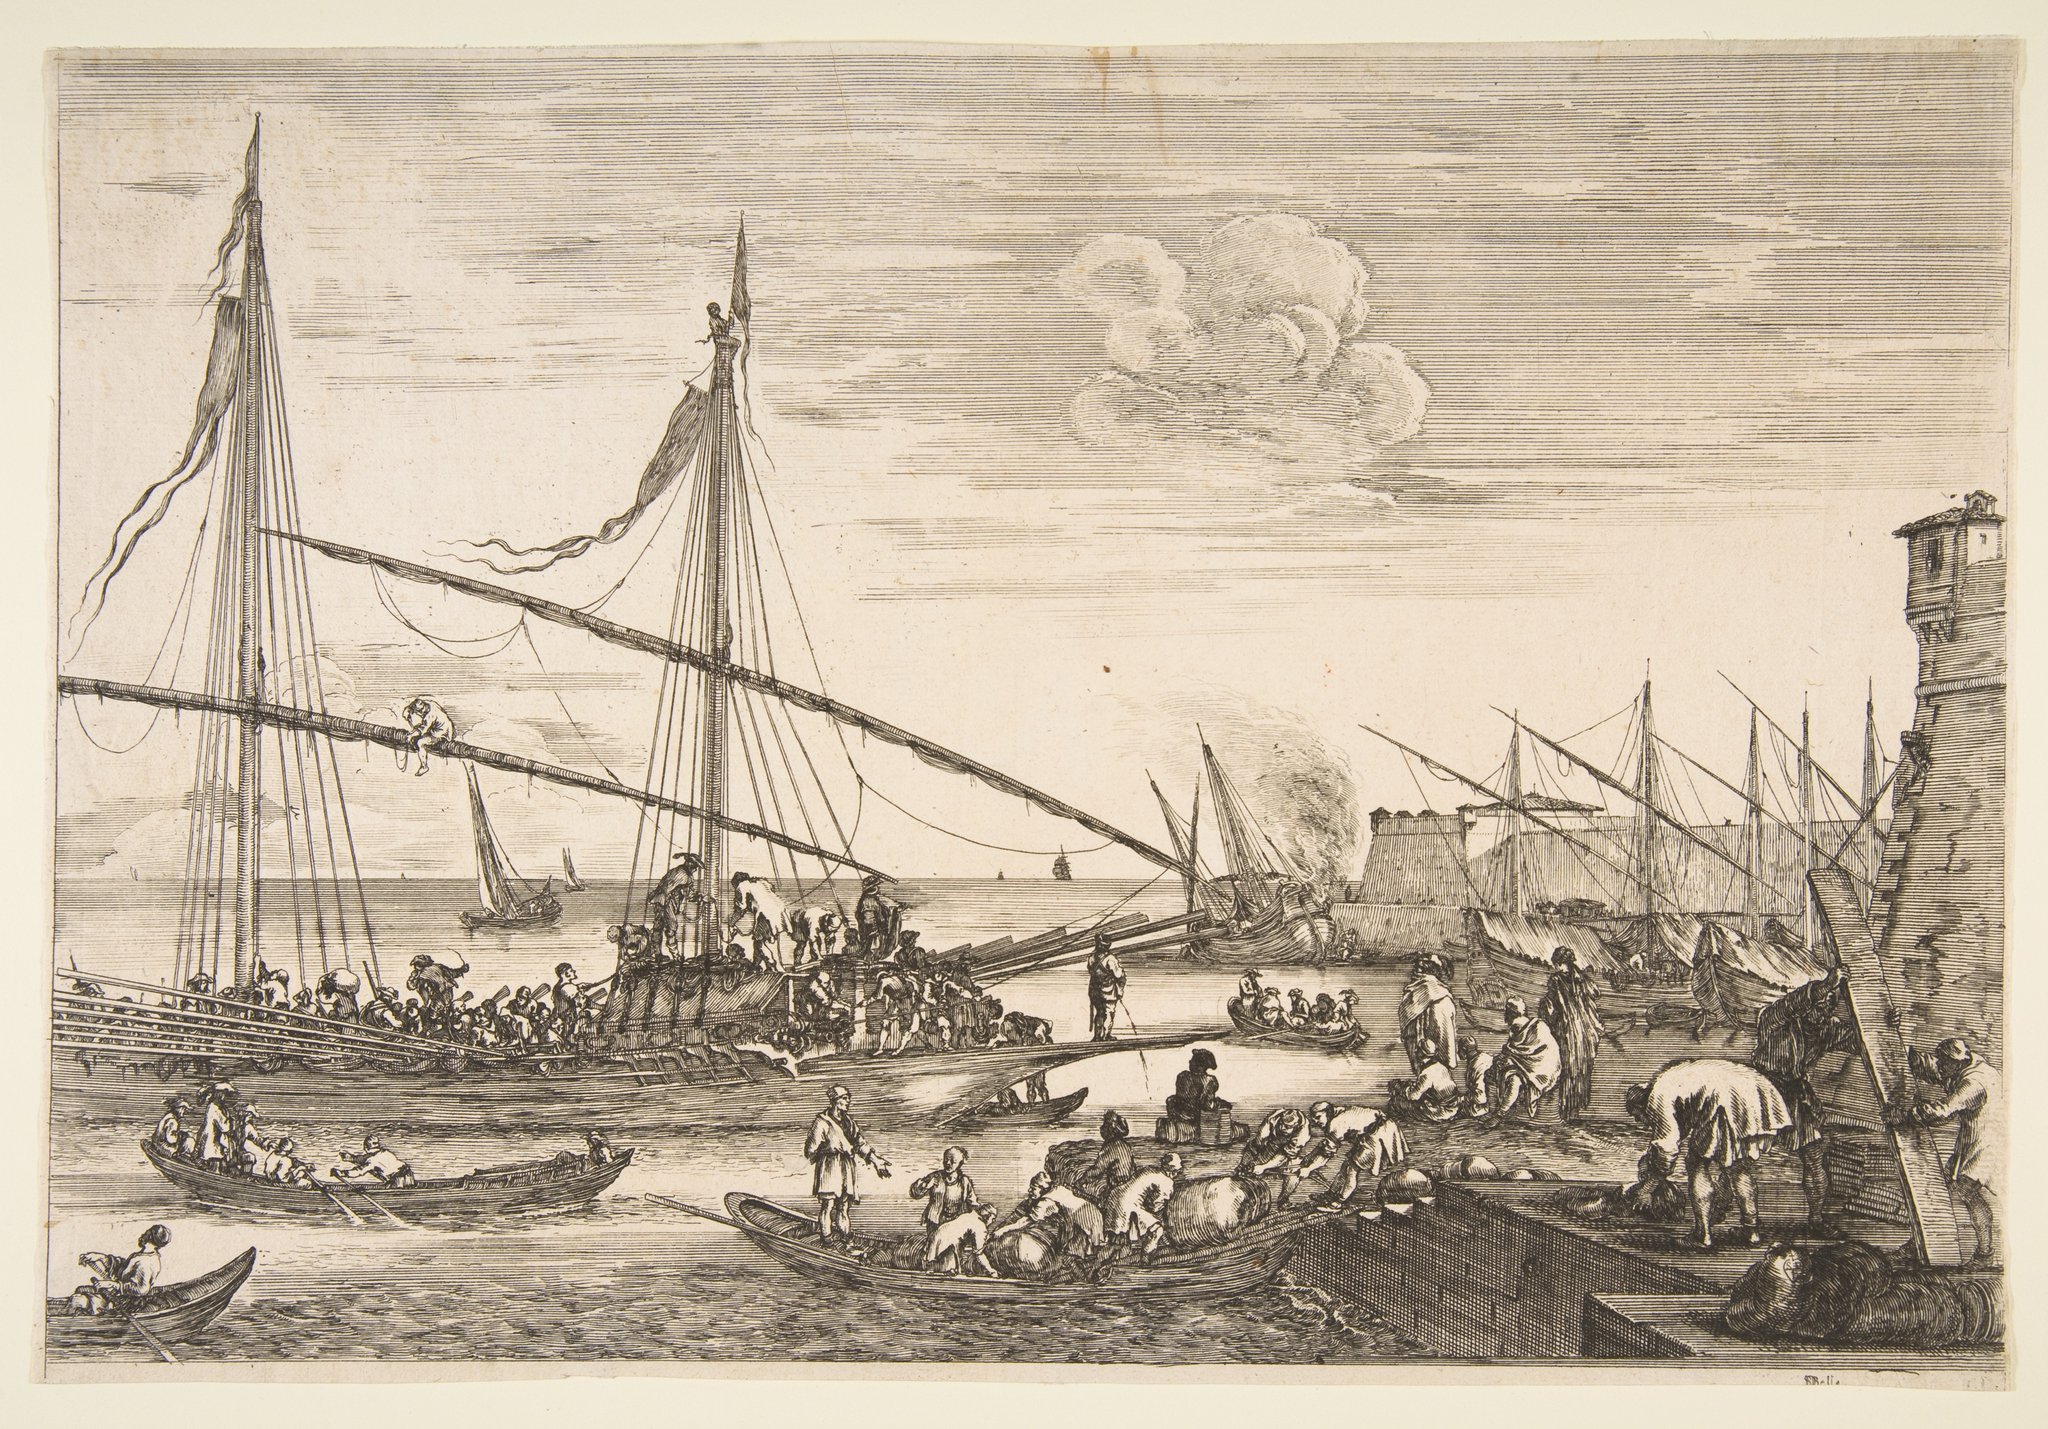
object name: print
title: View of the fortifications, two men lifting a plank at right, several ships and boats the background and a galley at left, from 'Views of the port of Livorno' (Vues du port de Livourne)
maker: stefano della bella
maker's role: artist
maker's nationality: italian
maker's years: 1610-1664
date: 1655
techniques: etching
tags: men,boats,ships